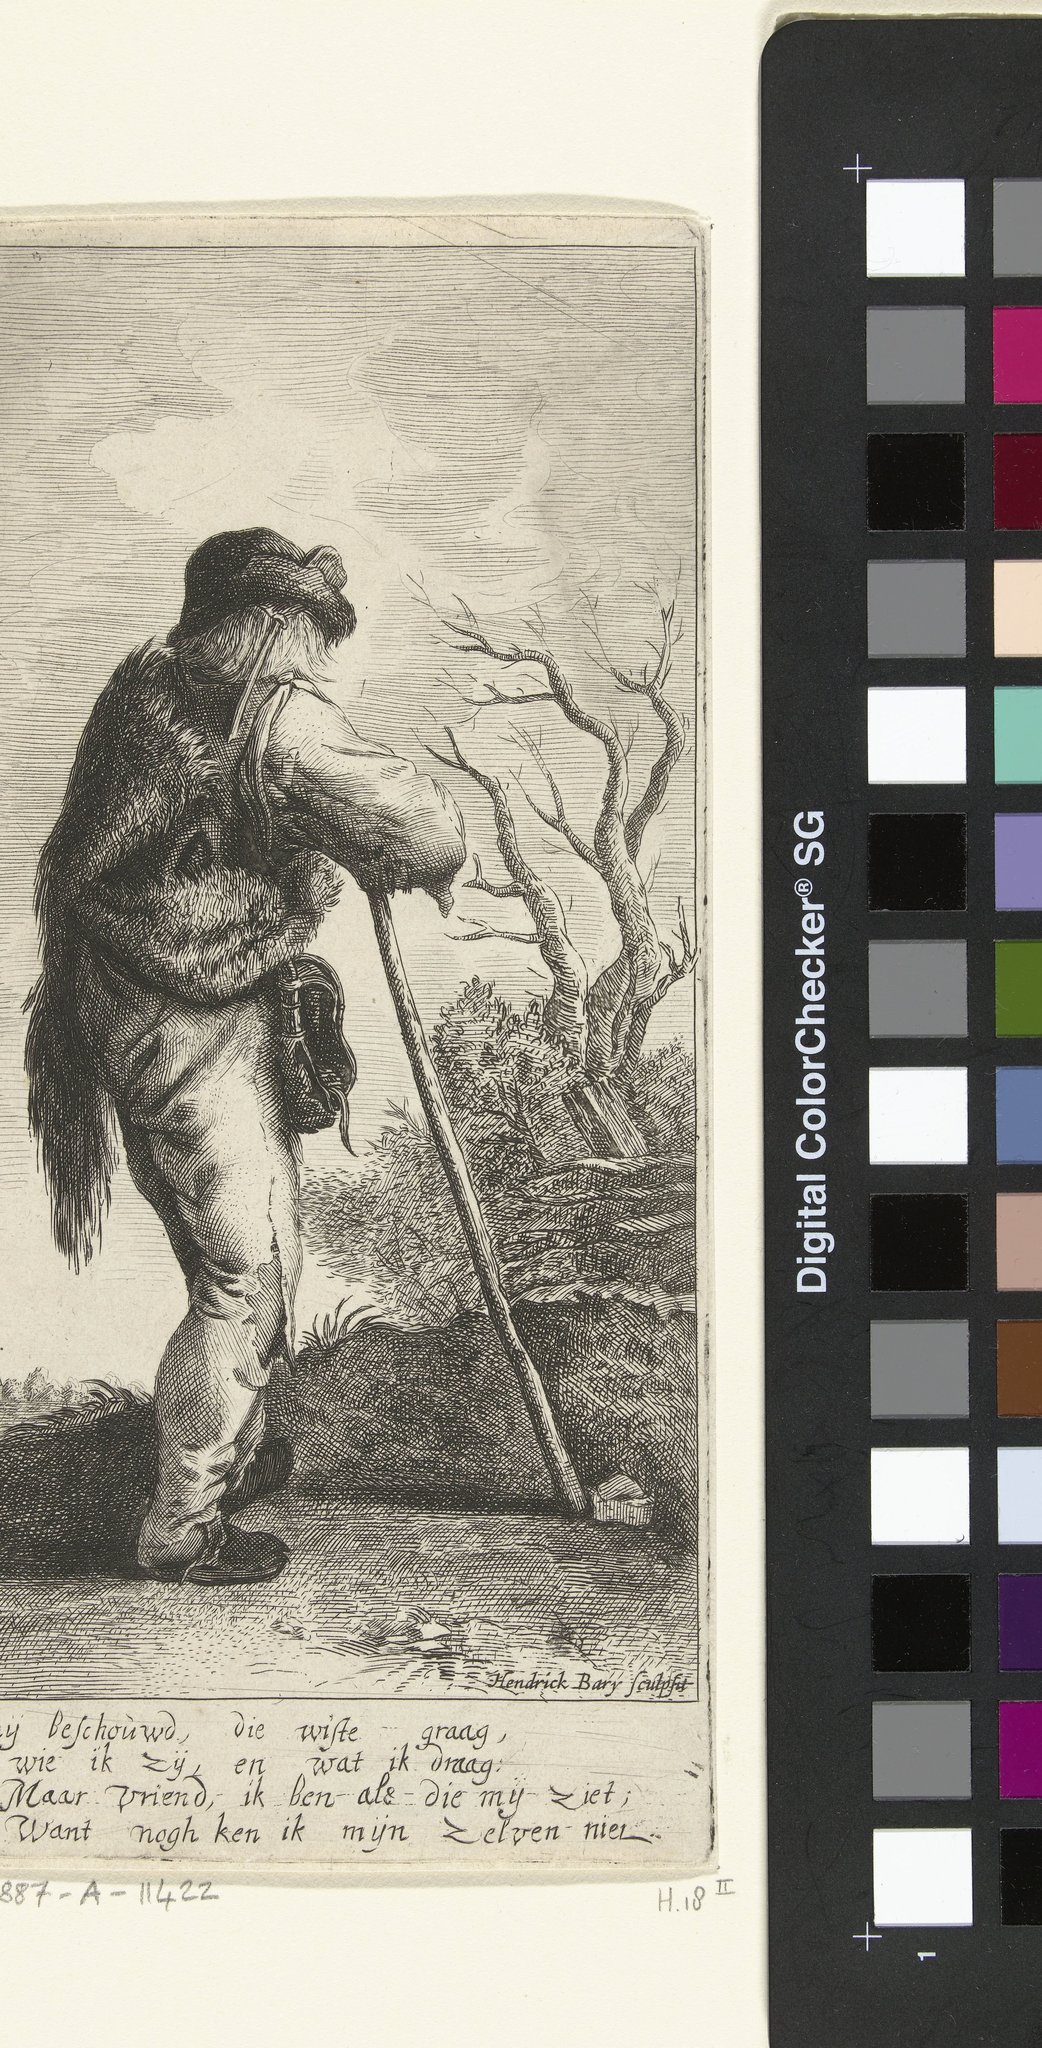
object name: print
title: Man die op een stok leunt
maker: hendrik bary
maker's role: draughtsman, print maker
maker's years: 1640-1707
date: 1657-1679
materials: paper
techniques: engraving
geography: netherlands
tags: the poor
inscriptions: collector's mark: Lugt 2228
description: Een arme man op de rug gezien, leunend op een stok. Onder de voorstelling een vers van vier regels in het Nederlands.